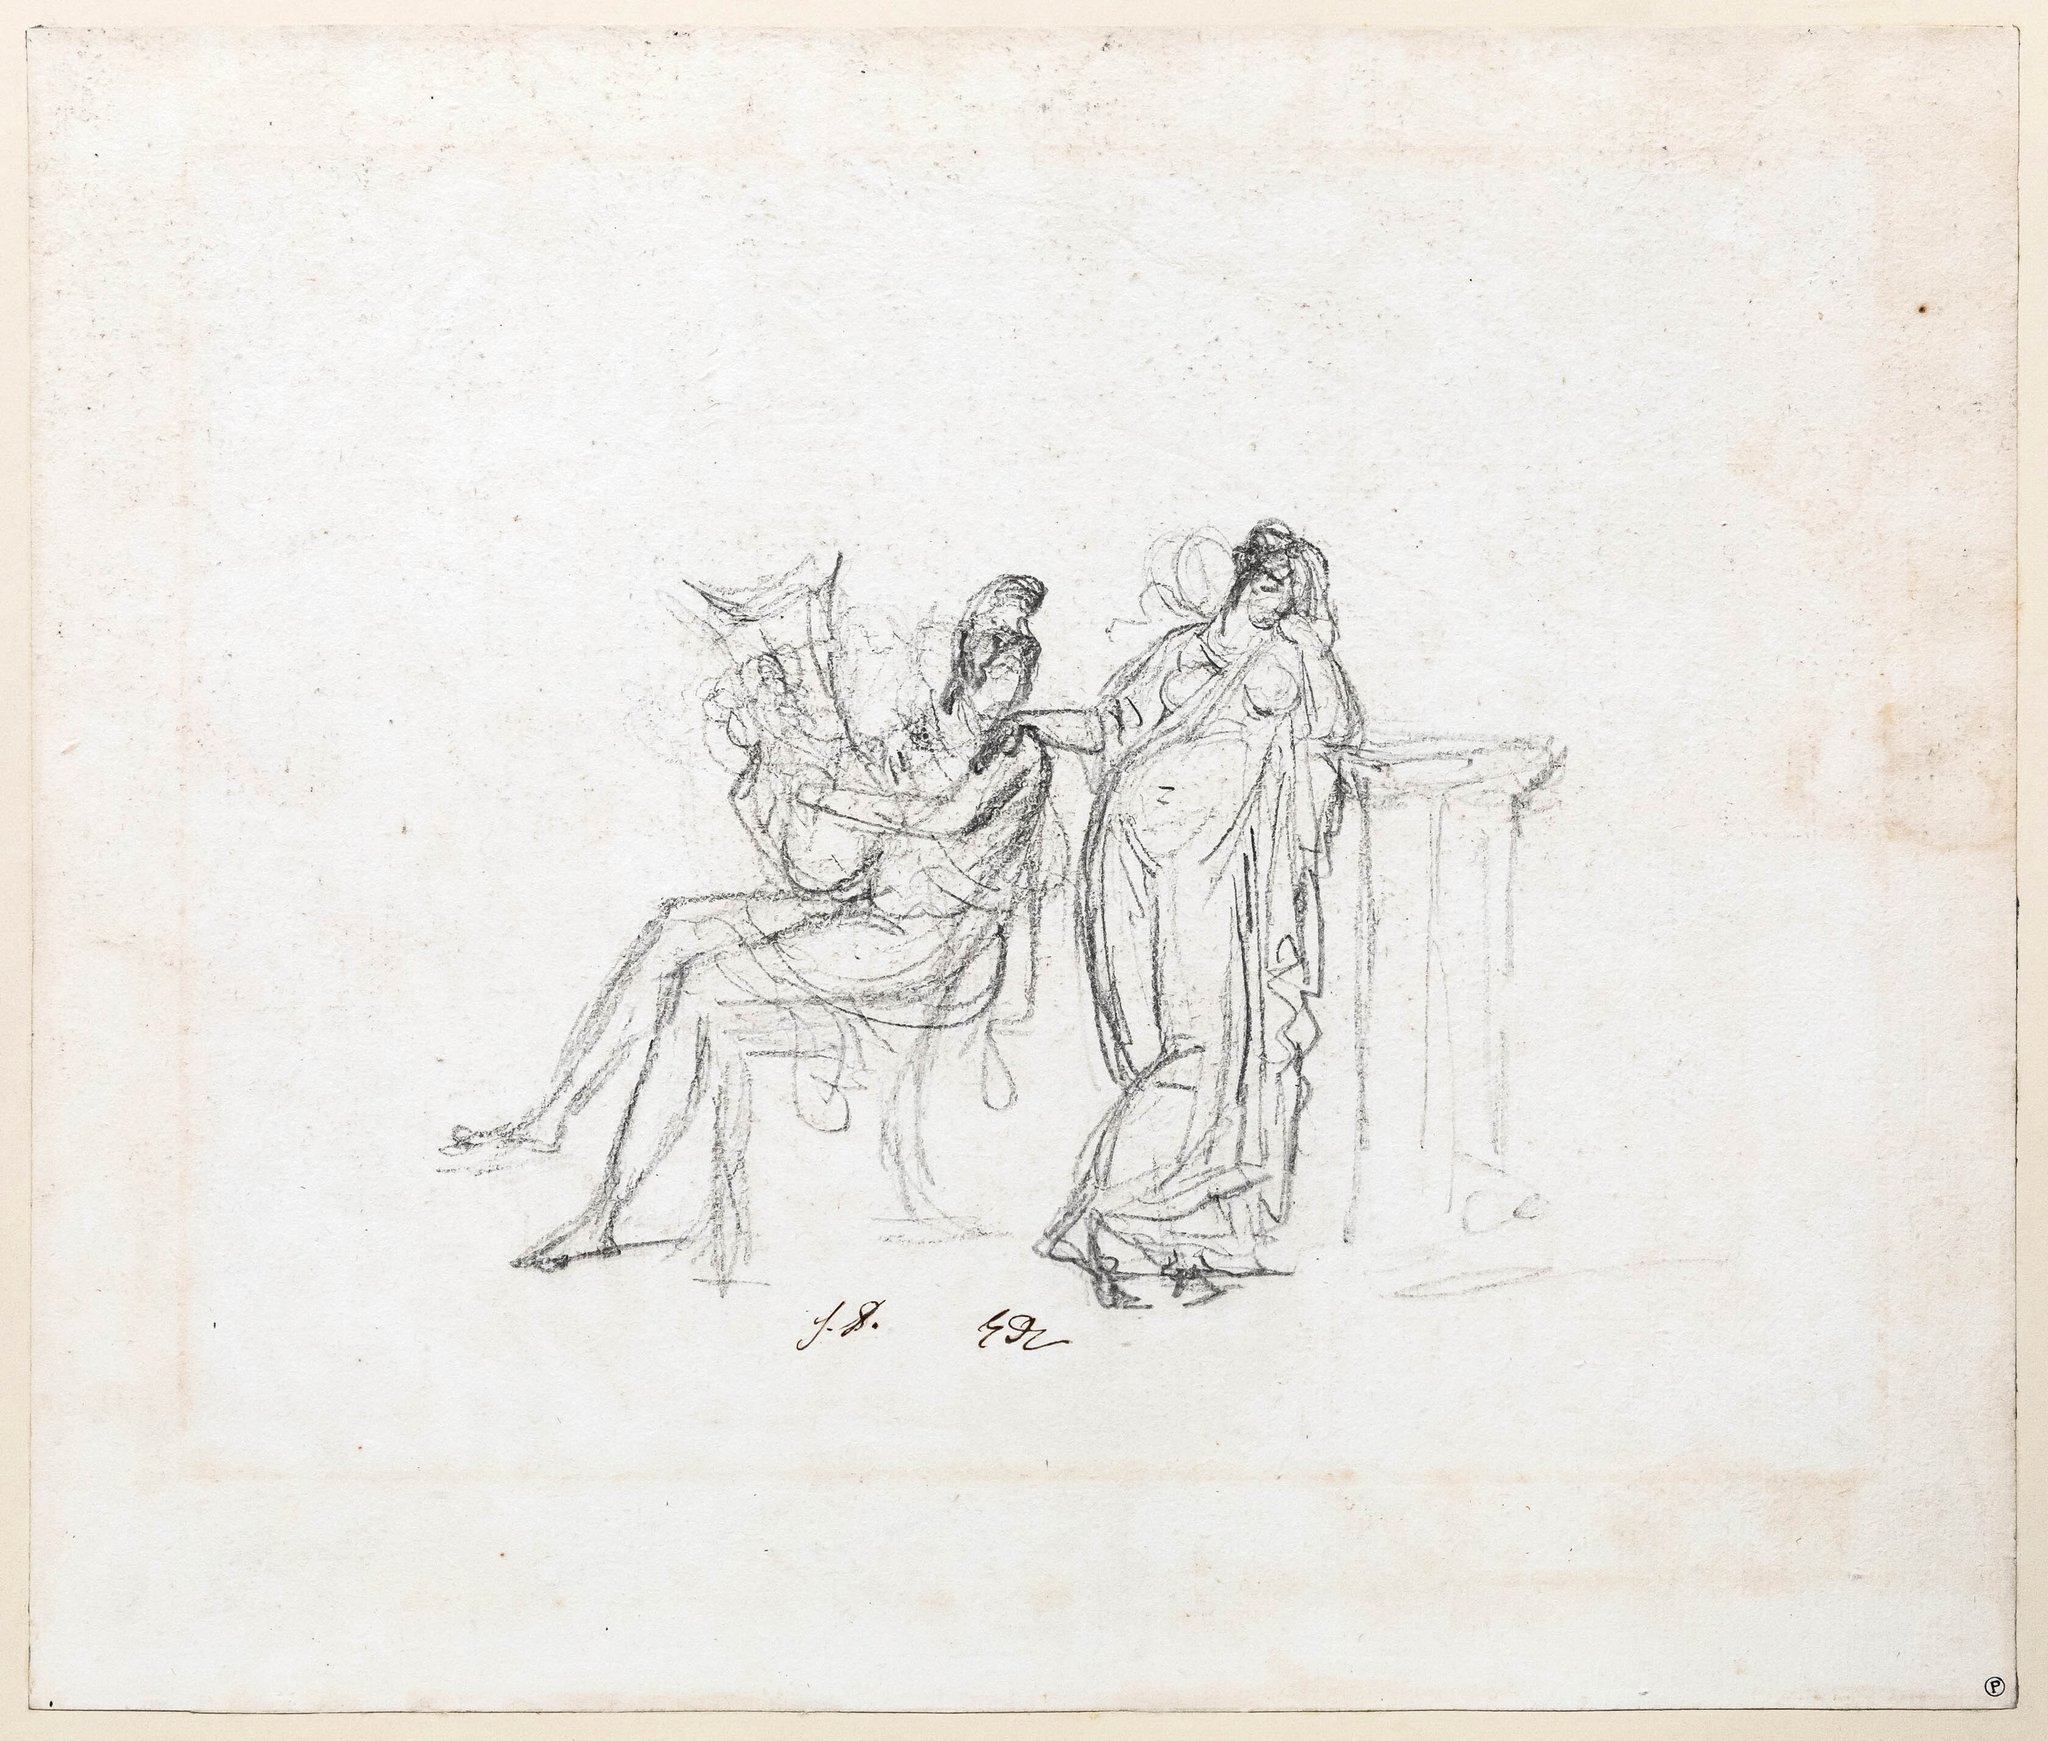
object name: drawing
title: Paris and Helen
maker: jacques louis david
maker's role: artist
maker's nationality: french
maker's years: 1748-1825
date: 1782-1786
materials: chalk